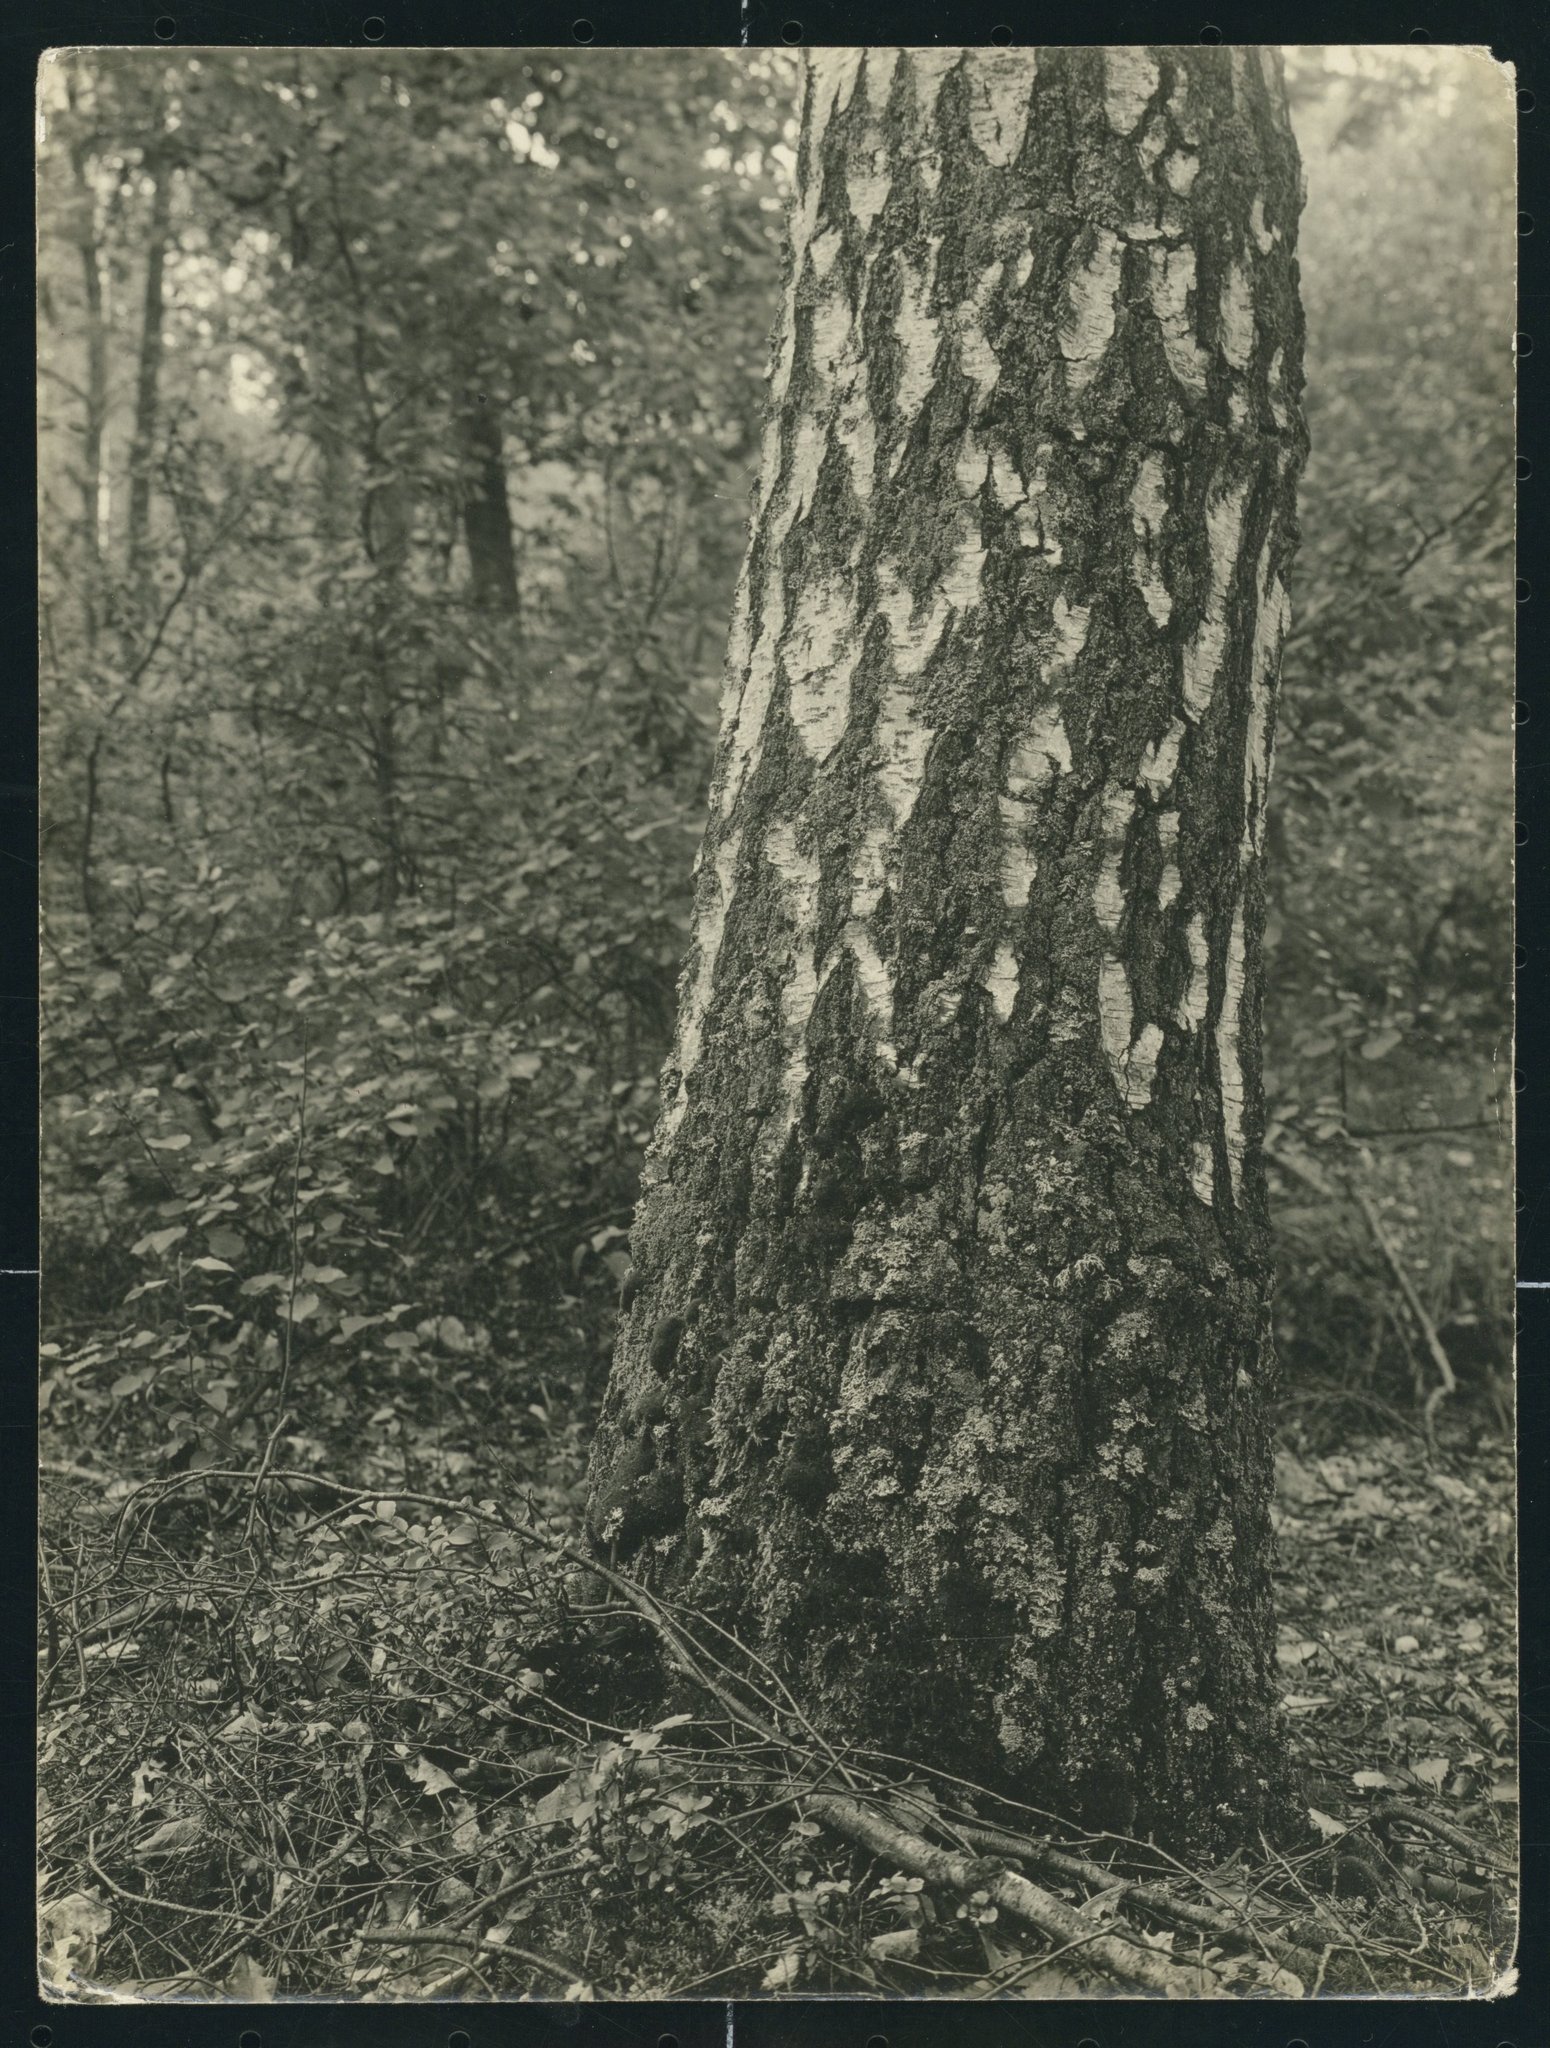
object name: photograph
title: Stam van de Reuzen Berk in het Willem Anne Bos bij Voorst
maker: richard tepe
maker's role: fotograaf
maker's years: 1864-1952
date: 1900-1930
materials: photographic support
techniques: gelatin silver print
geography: netherlands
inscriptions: signature: ‘foto R. Tepe’, title: ‘Stam van den Reuzen Berk in het Willem Anne Bosch onder Voorst Weiss Birkenstamm im Wilhelm Anna Wald im Voorst (Holland)’